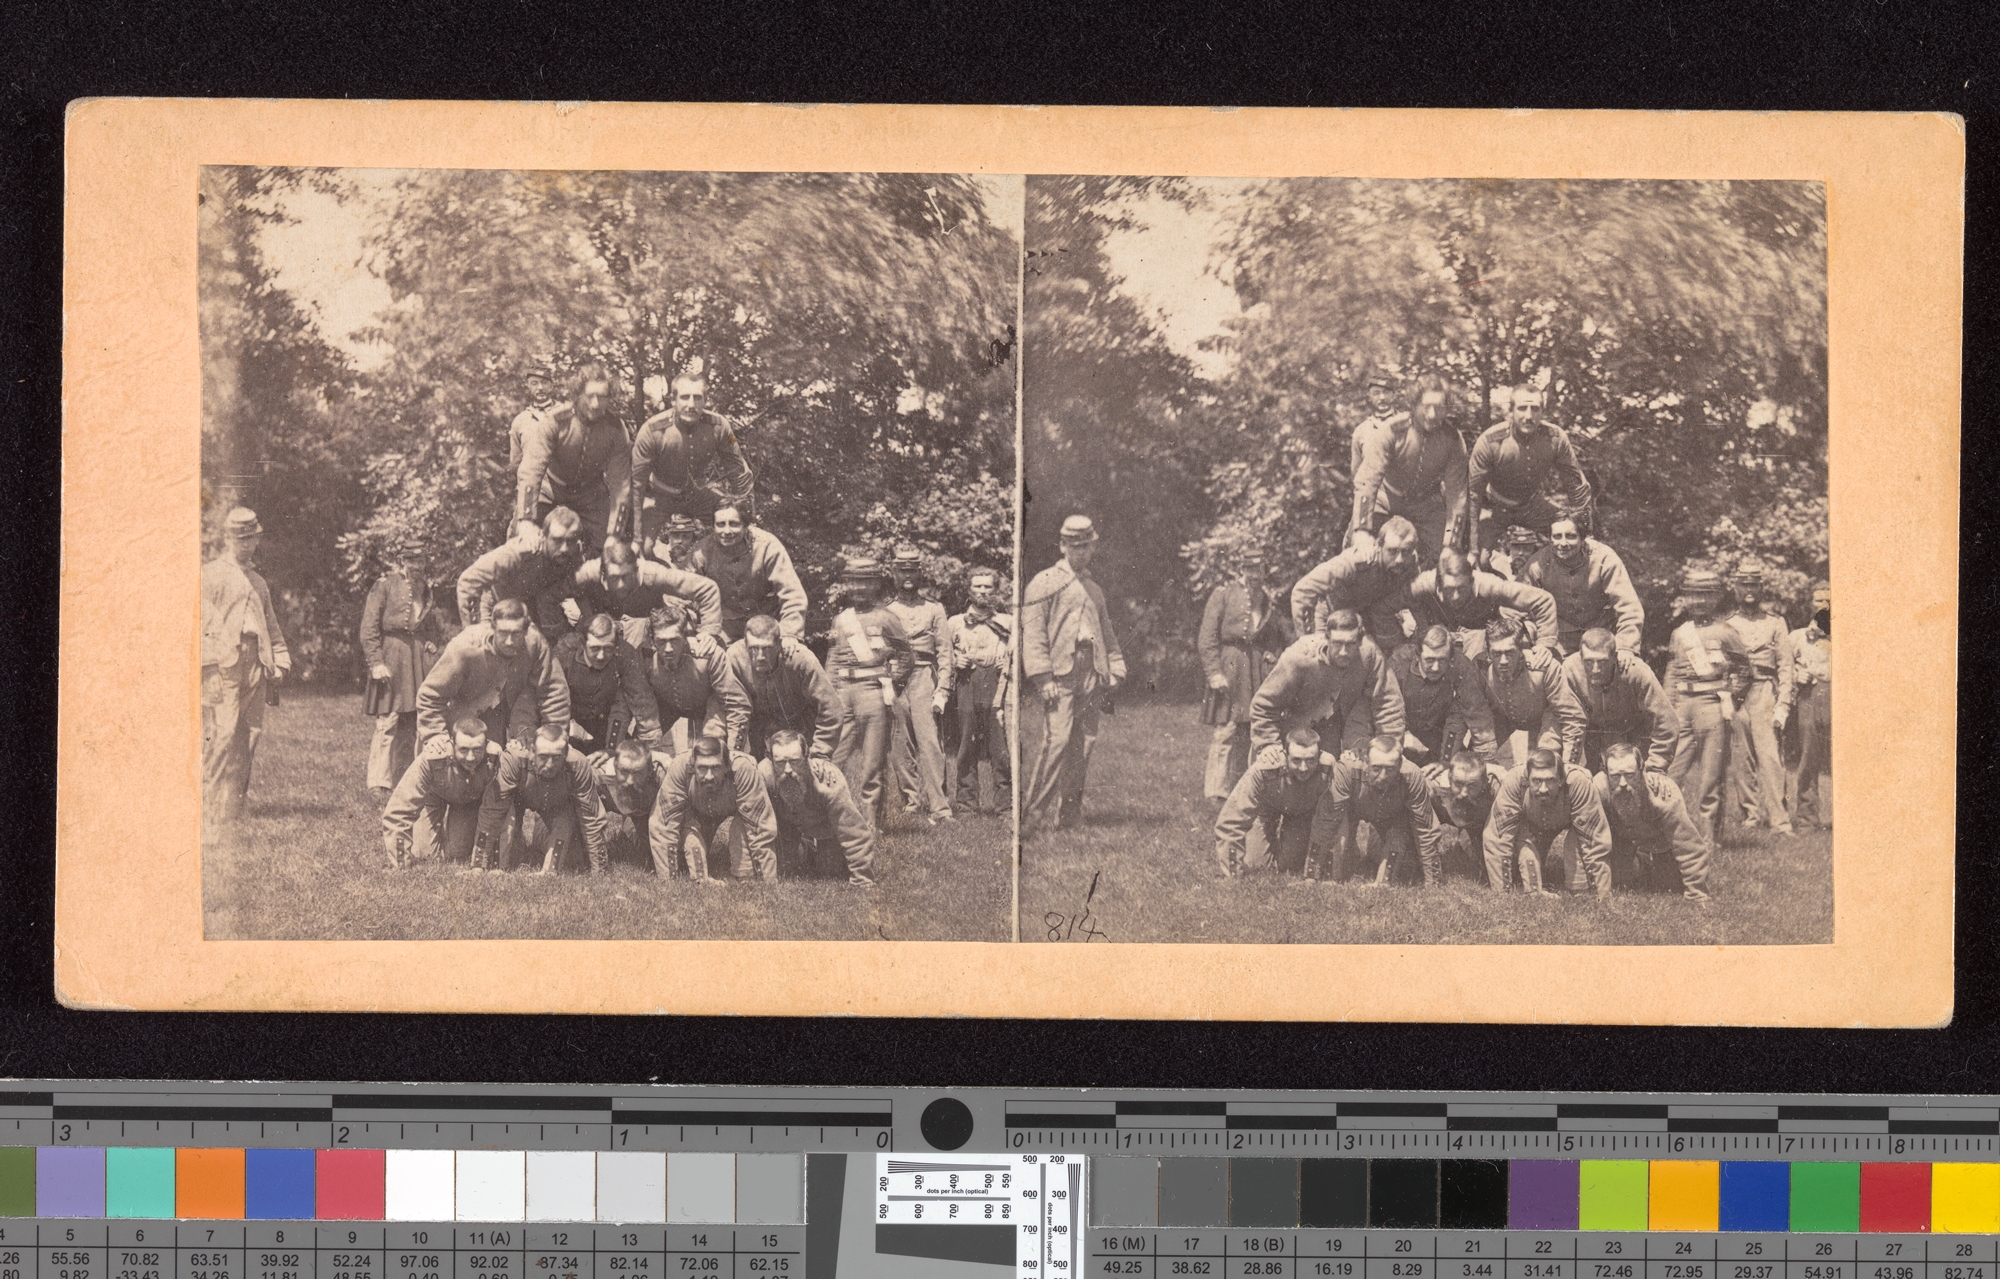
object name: stereograph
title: [250 Stereographs of U.S. Views]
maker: various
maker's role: artist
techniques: albumen silver print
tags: cities,soldiers,men